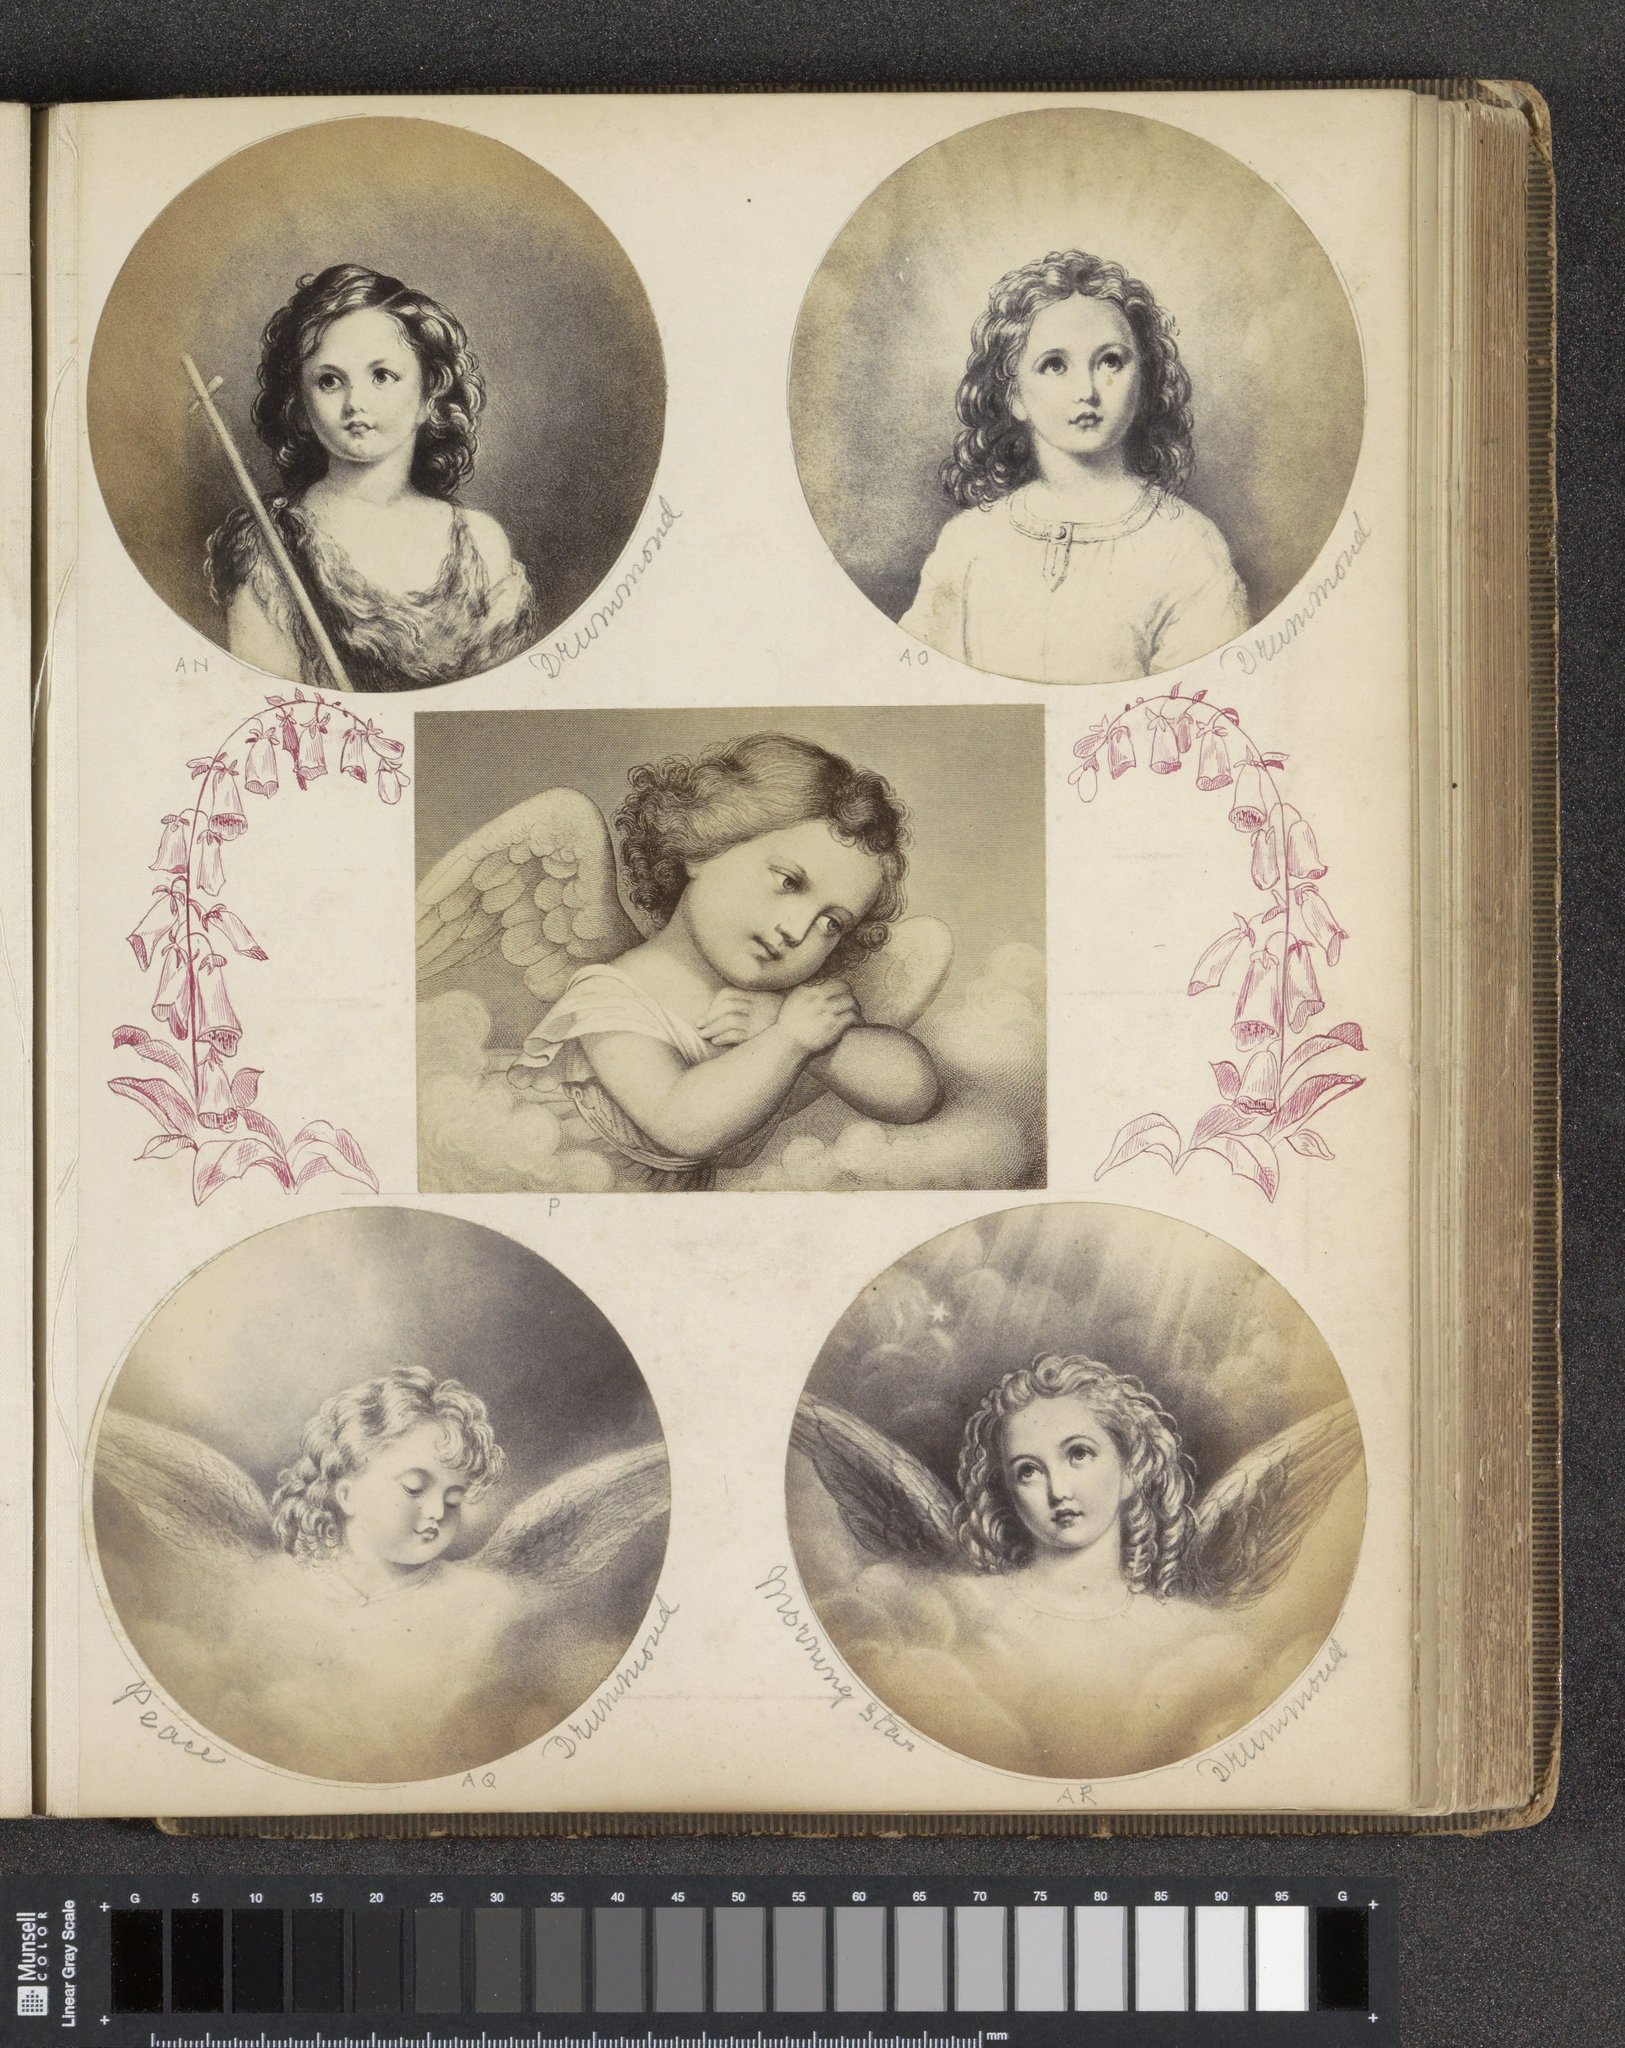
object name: photograph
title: Fotoreproductie van (vermoedelijk) een tekening voorstellend Johannes de Doper als kind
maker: Anonymous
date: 1850-1870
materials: paper, photographic support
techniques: albumen print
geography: england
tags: john the baptist; possible attributes: book, reed cross, baptismal cup, honeycomb, lamb, staff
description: Onderdeel van Album met foto's van bezienswaardigheden en landschappen in Engeland en van kunst.